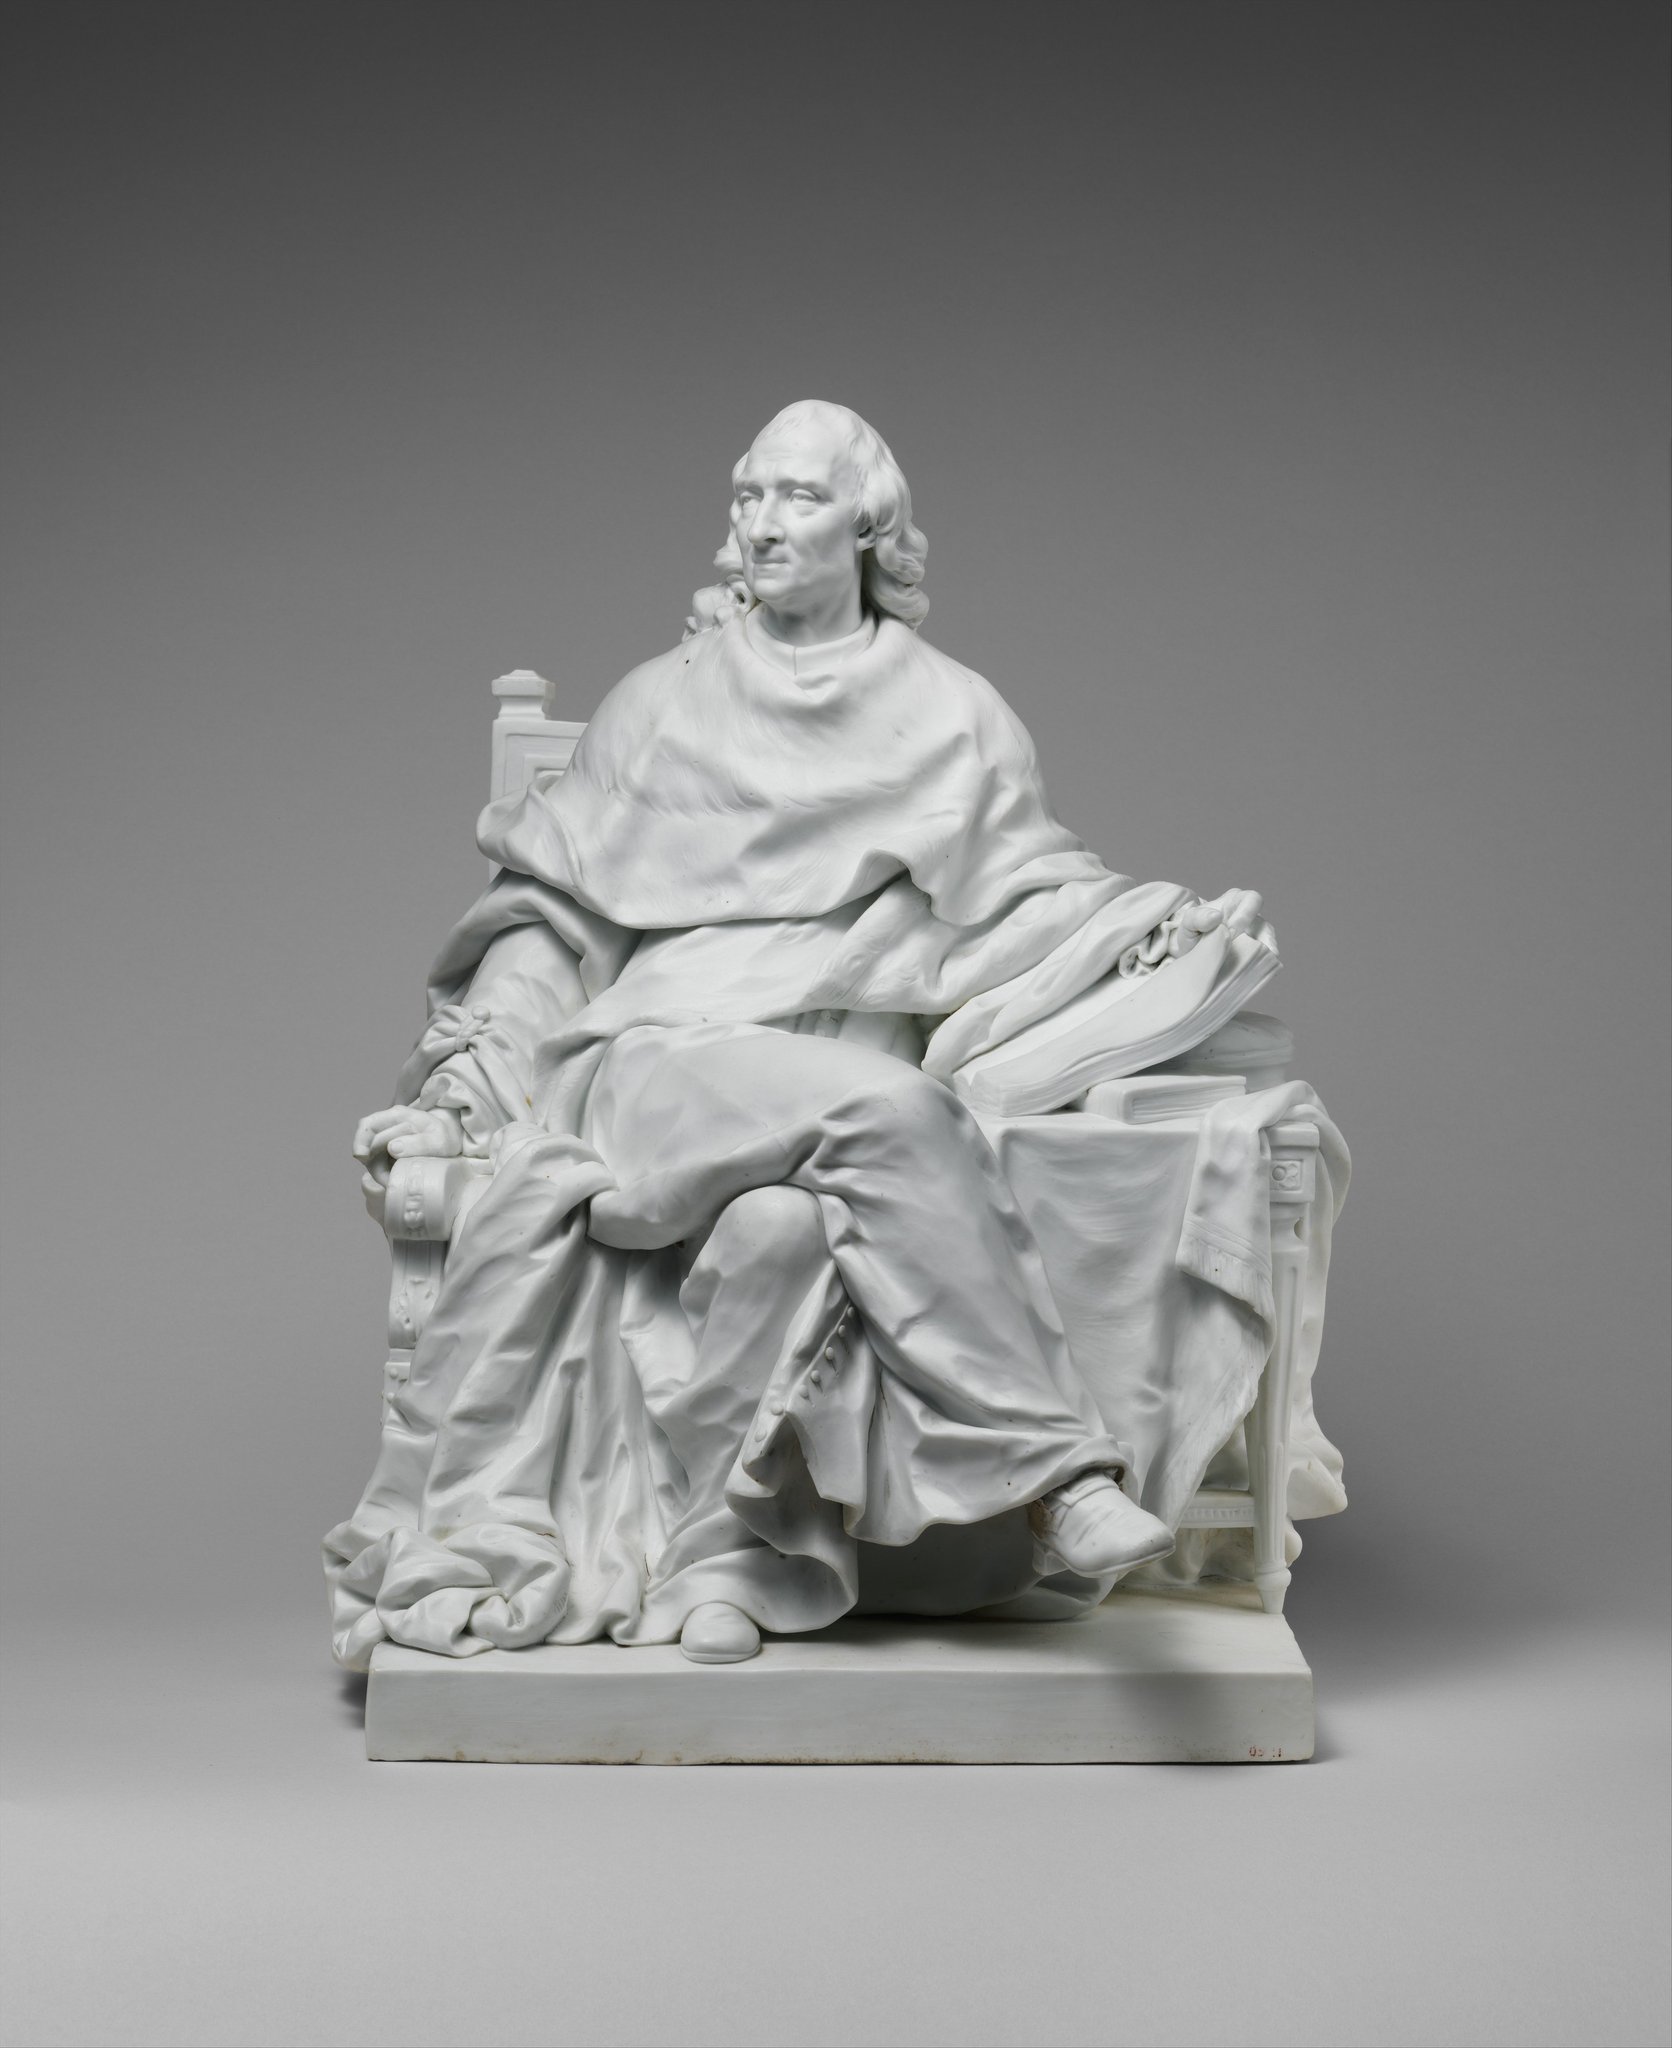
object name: figure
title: Charles-Louis de Secondat (1689–1755), baron de La Brède et de Montesquieu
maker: sèvres manufactory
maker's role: manufactory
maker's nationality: french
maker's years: 1740-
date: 1784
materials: biscuit, paste, porcelain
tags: men